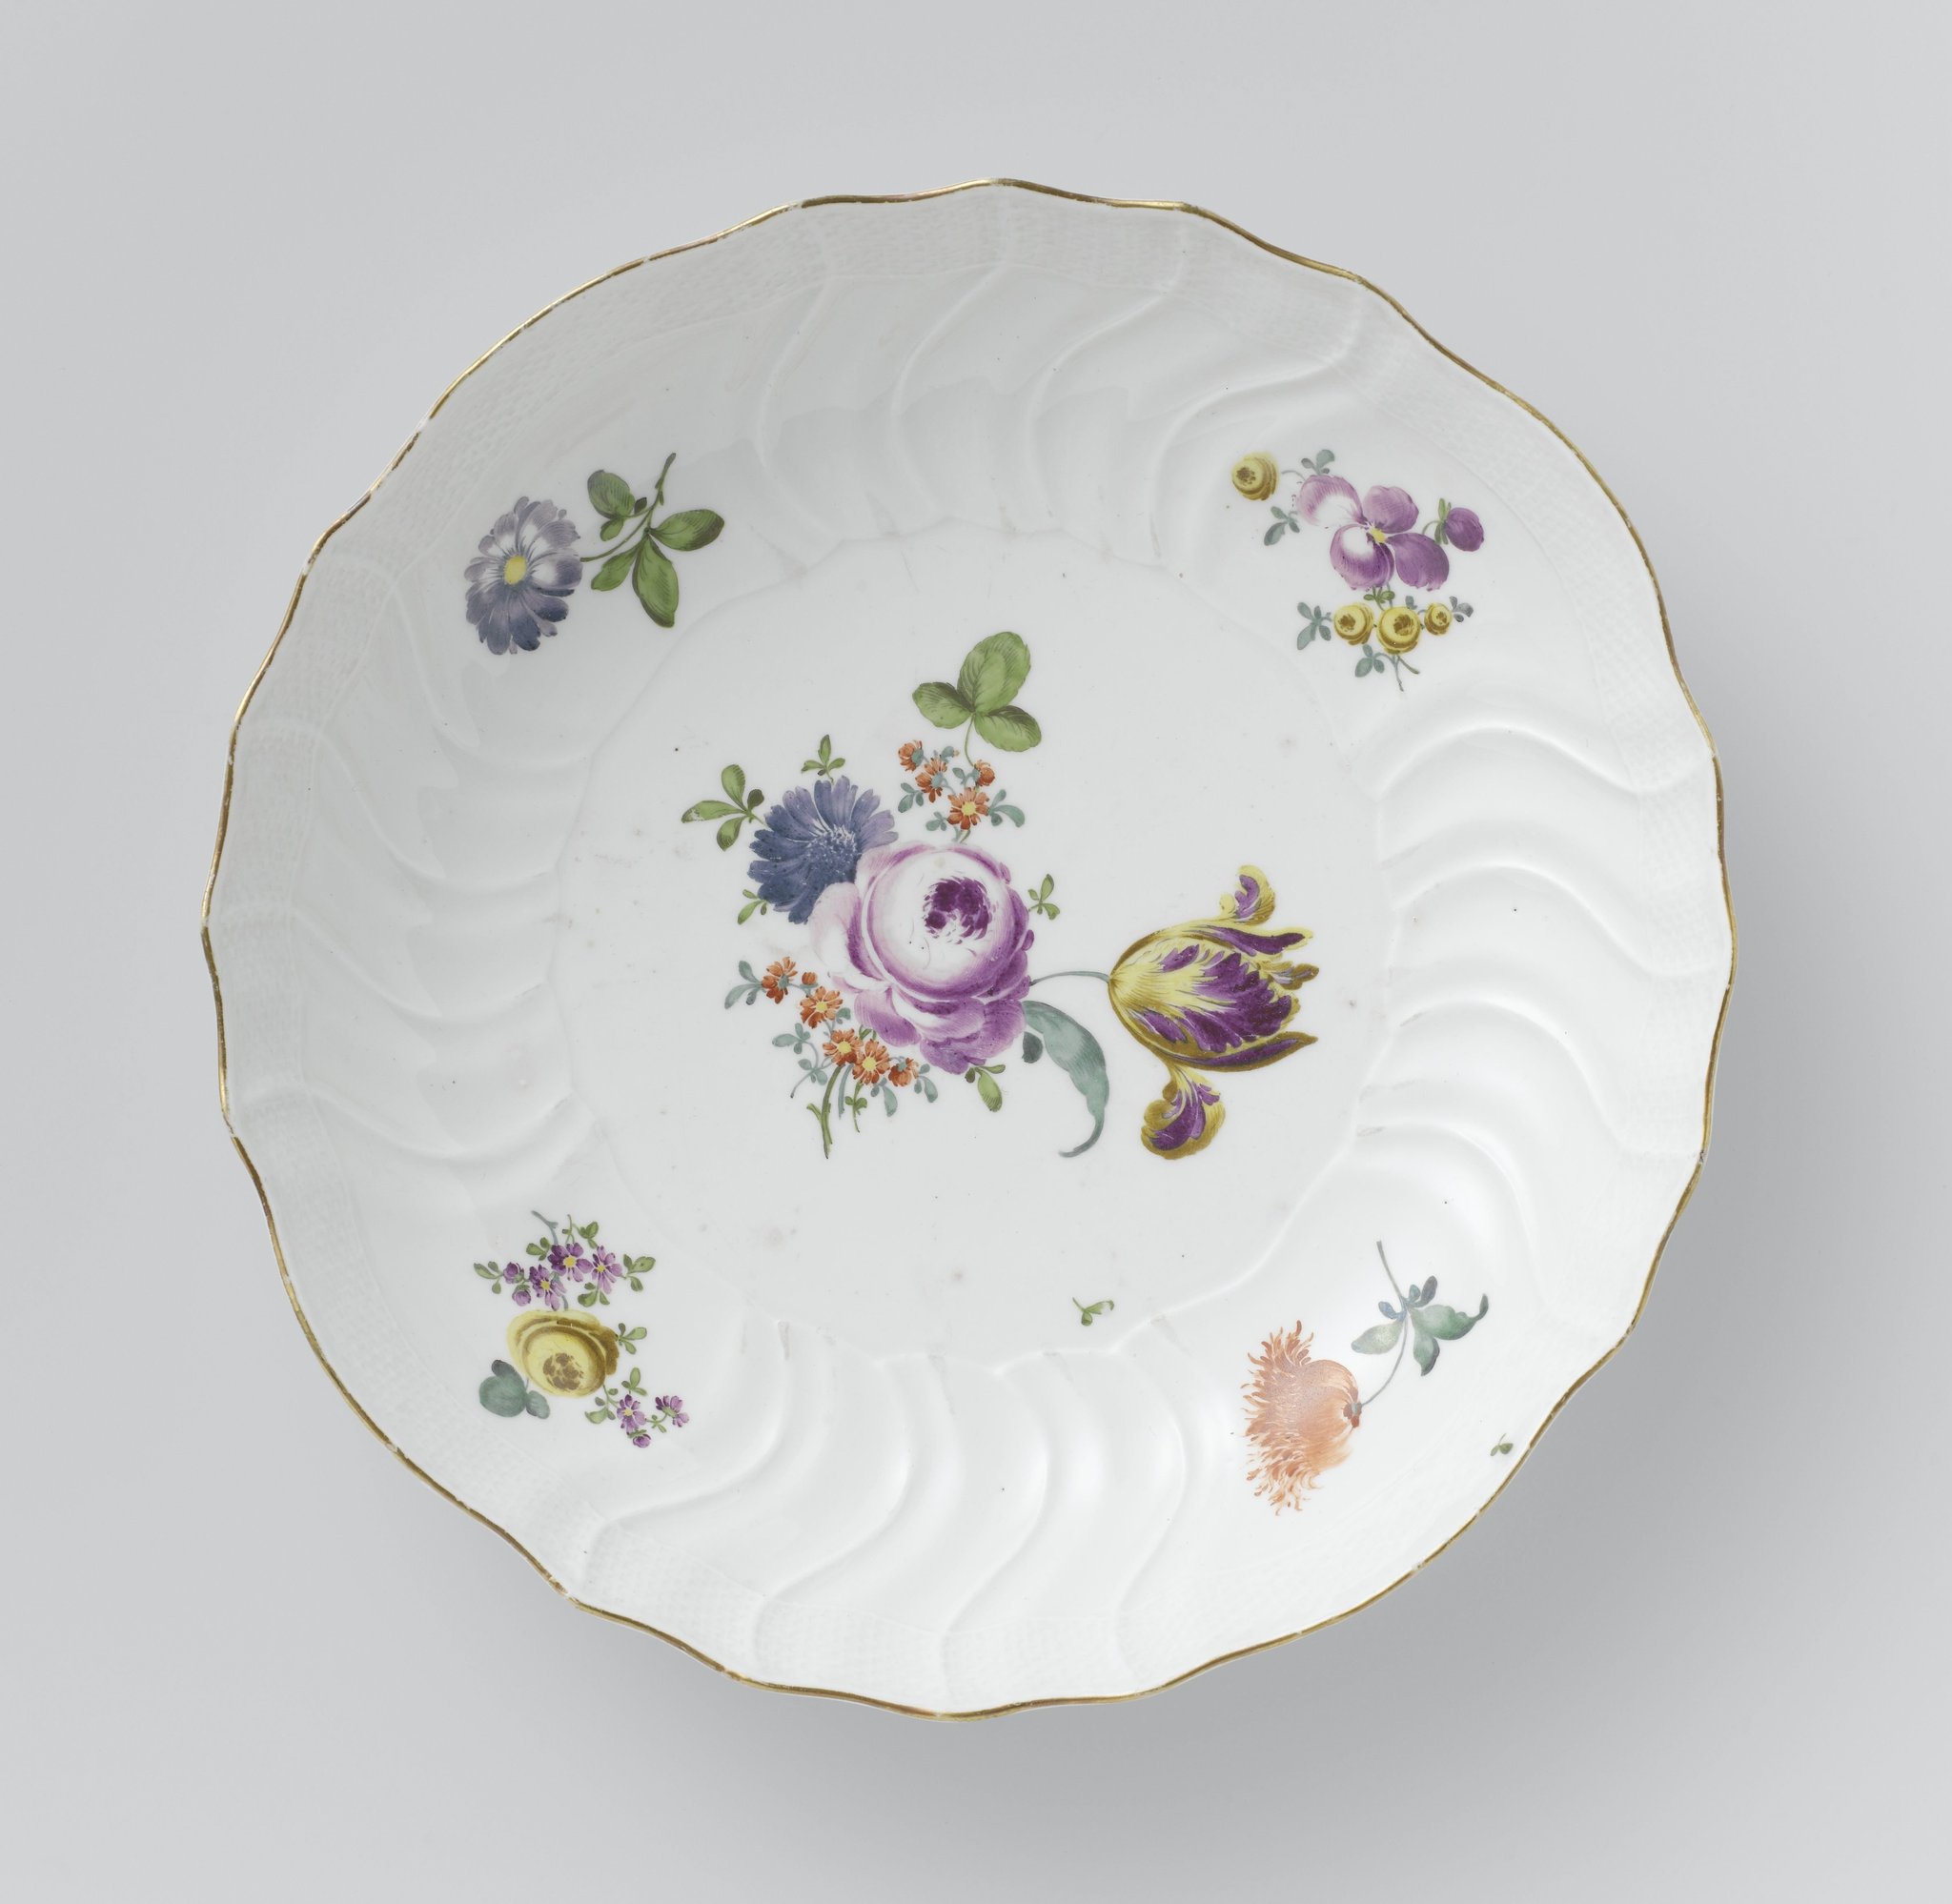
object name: platter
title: Schotel, veelkleurig beschilderd met Deutsche Blumen, insekten en vruchten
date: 1750-1760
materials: porcelain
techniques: painted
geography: meissen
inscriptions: factory mark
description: Ronde schotel van beschilderd porselein. De schotel is beschilderd met Deutsche Blumen, insekten en vruchten. De rand is in reliëf versierd met het Neuozier-patroon. De schotel is gemerkt en hoort bij een servies (BK-17474-1 t/m BK-17474-253).